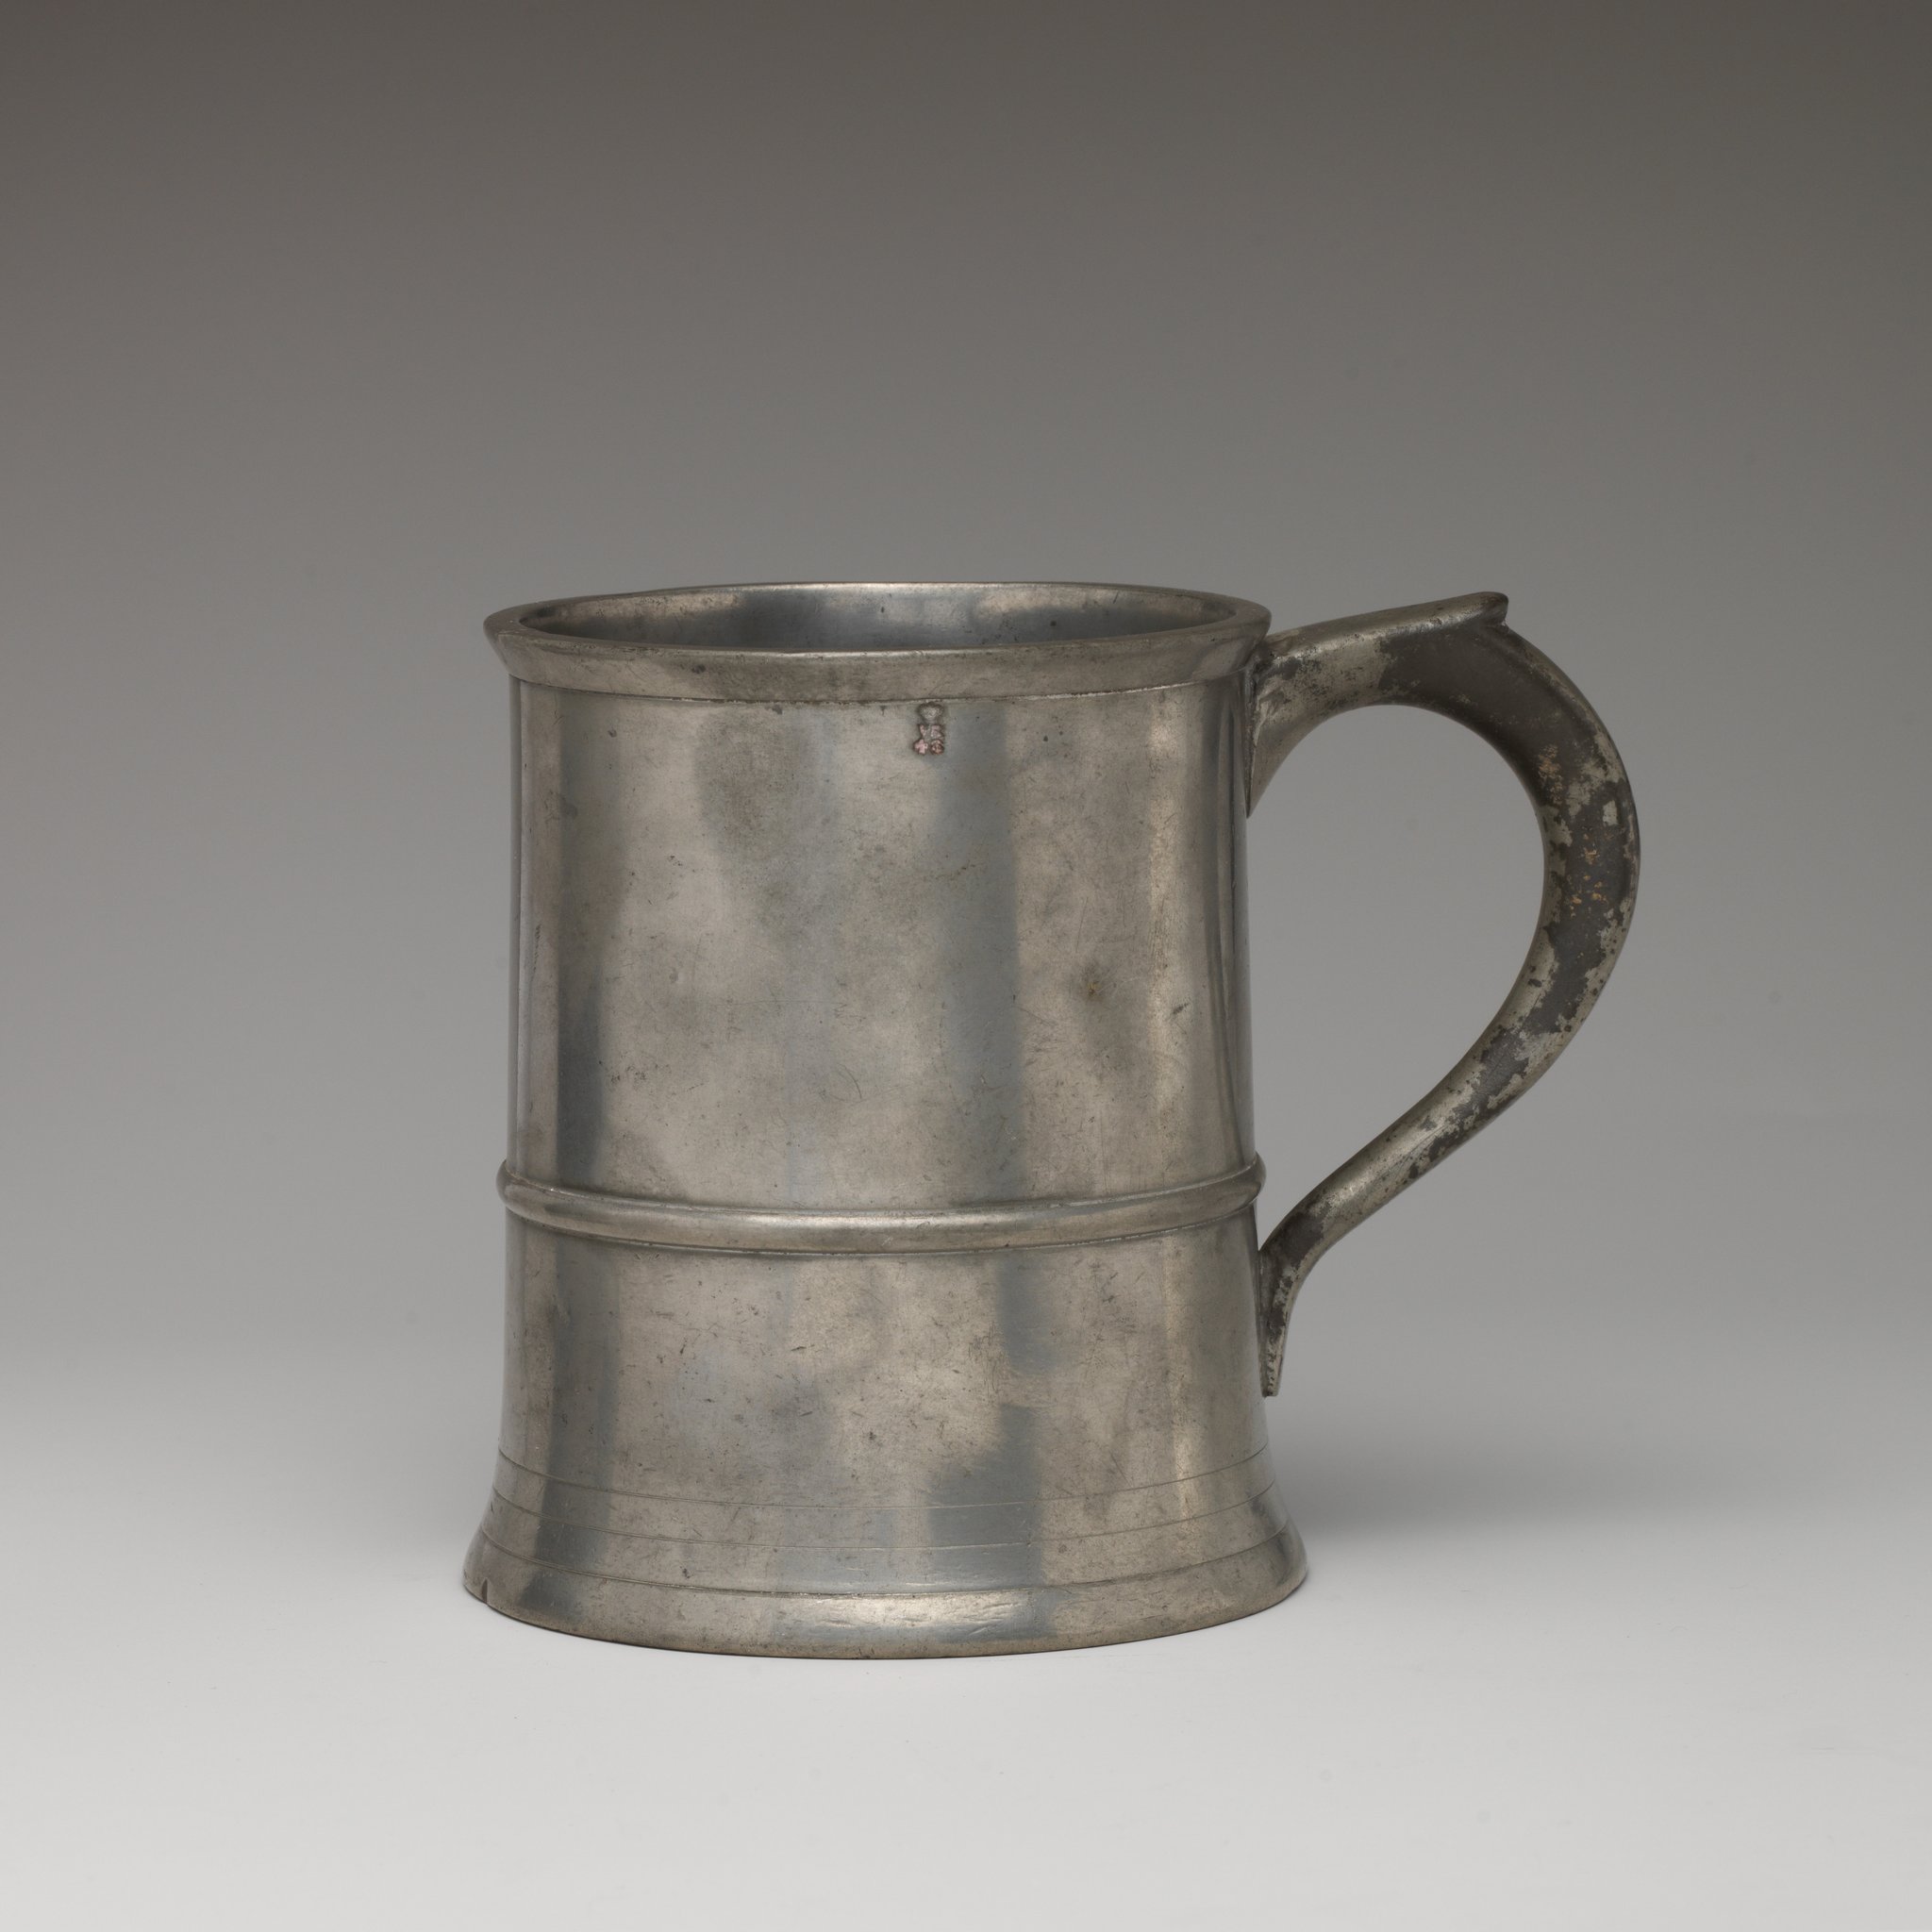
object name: measure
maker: thomas abbott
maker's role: maker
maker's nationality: british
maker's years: 1769-1852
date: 1767-1833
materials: pewter